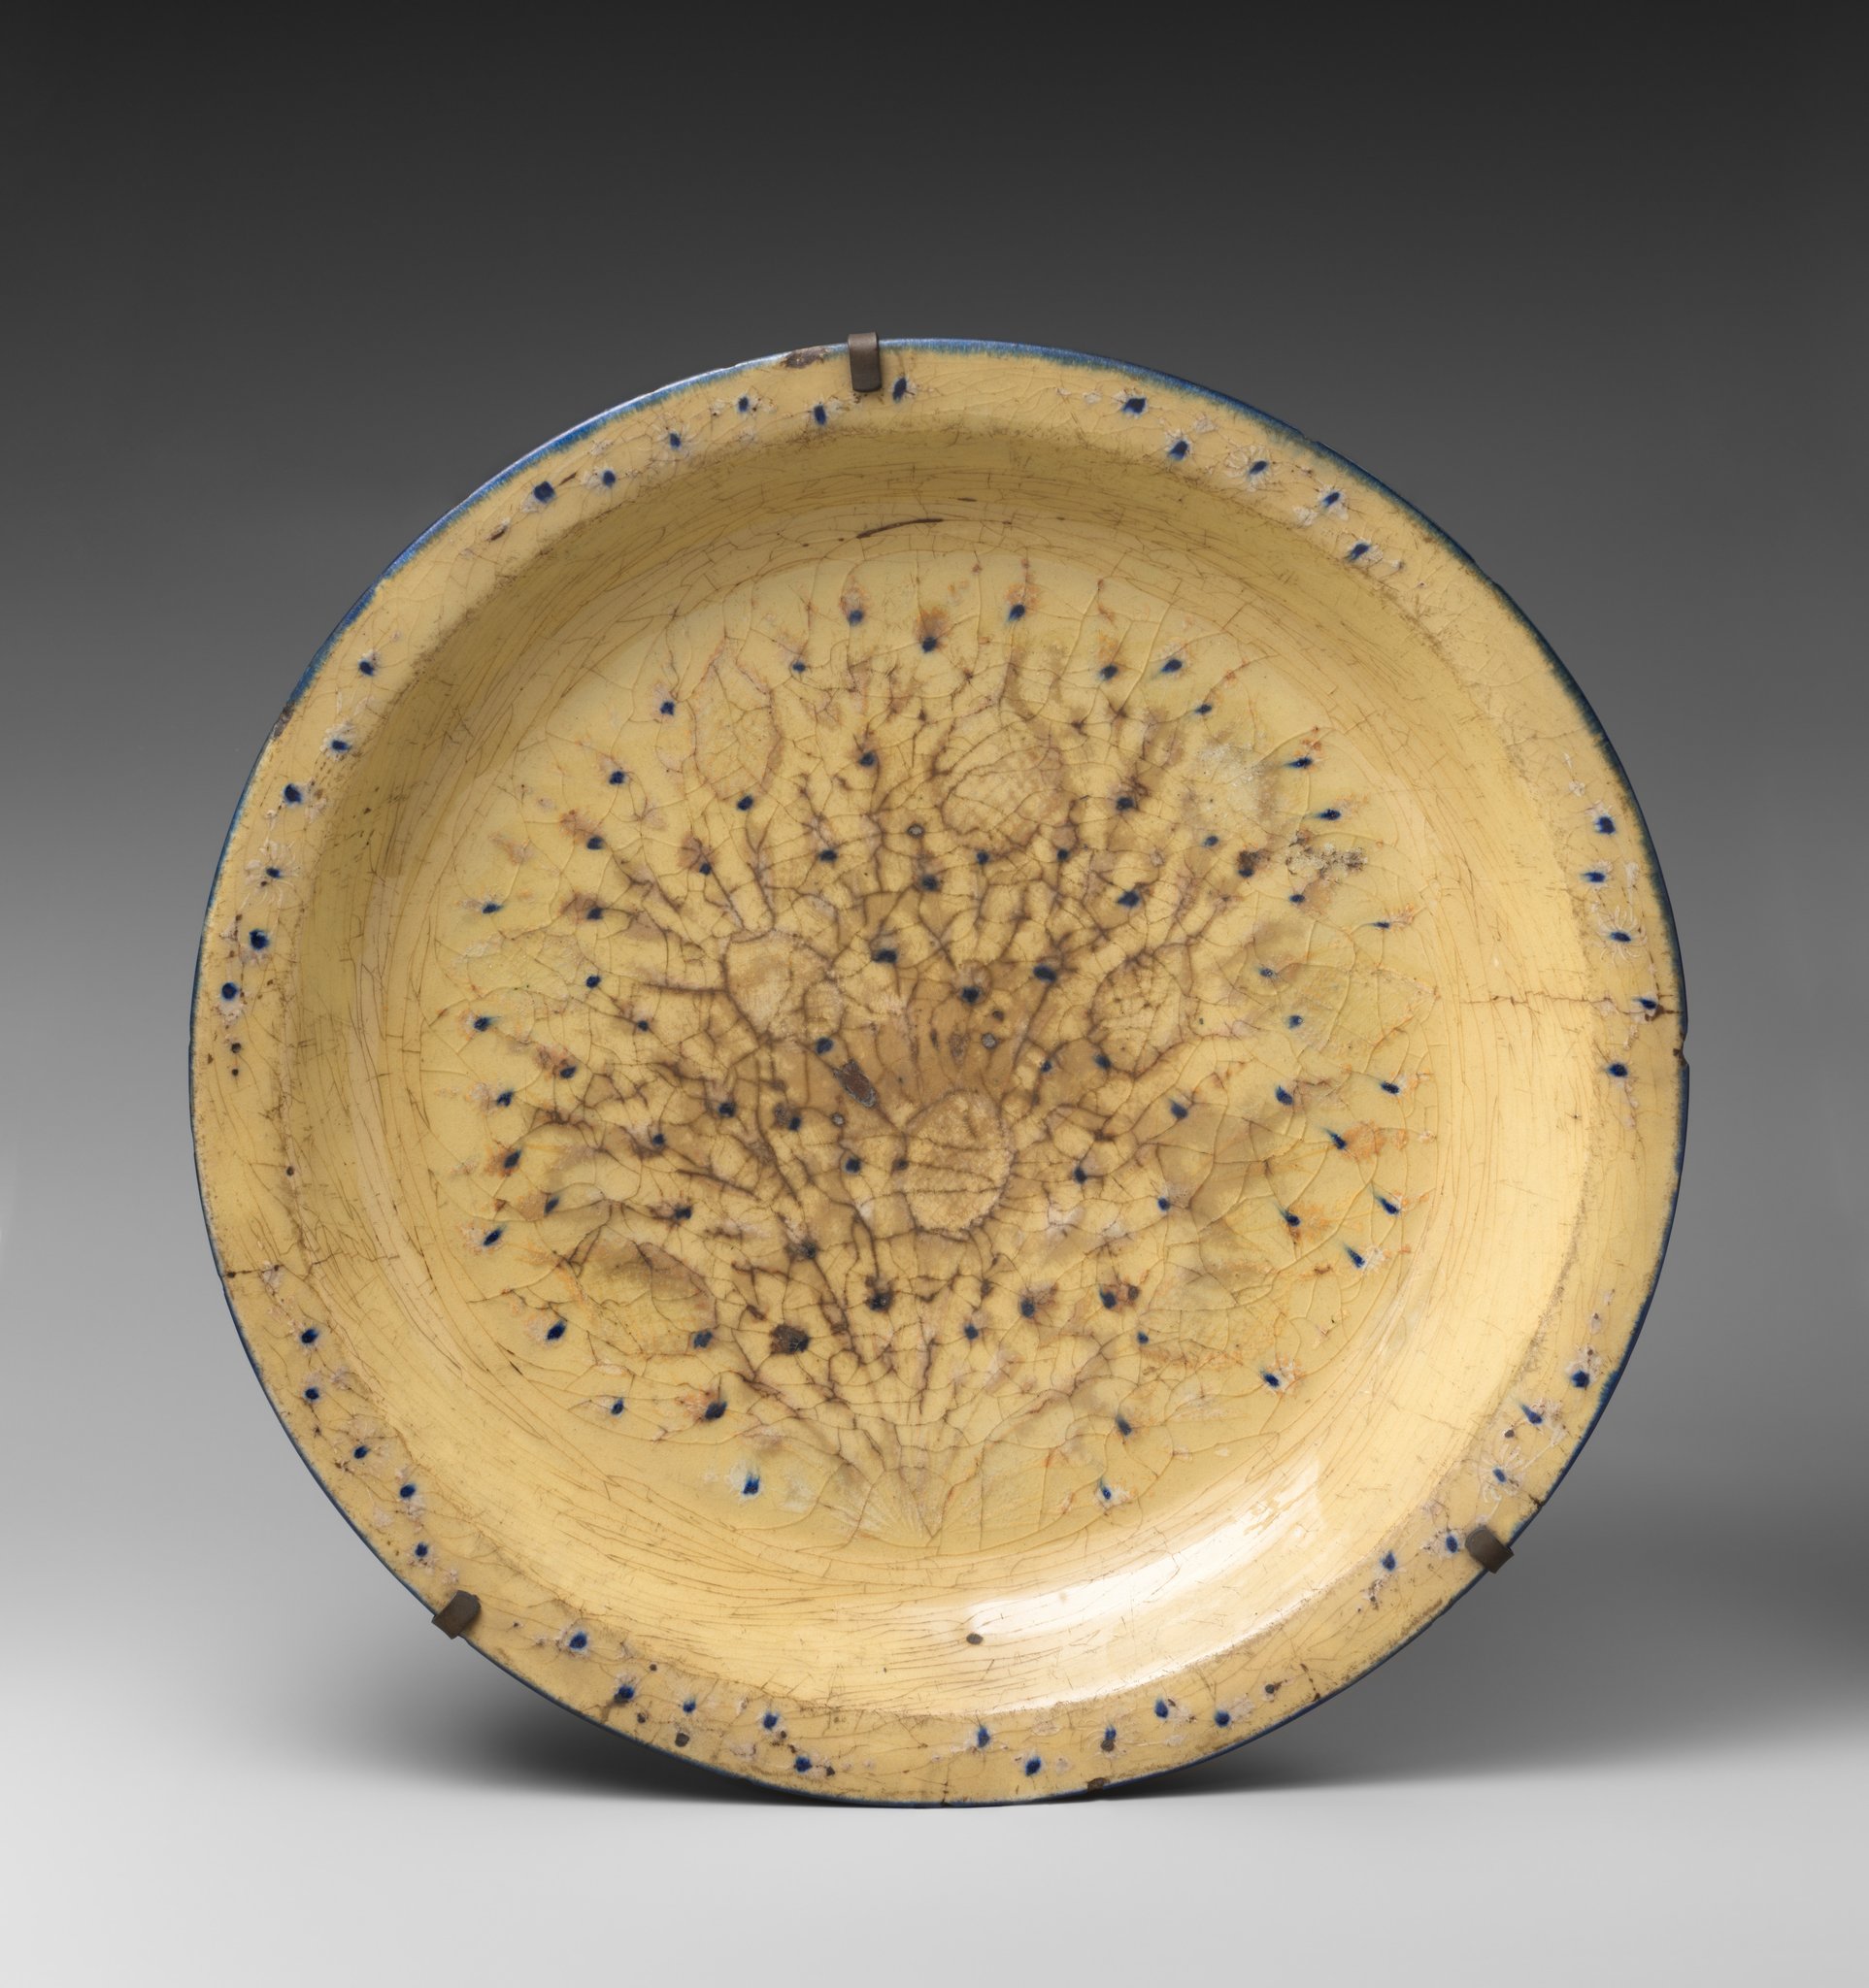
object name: dish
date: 1701-1800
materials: stonepaste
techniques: glazing, painting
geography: kerman